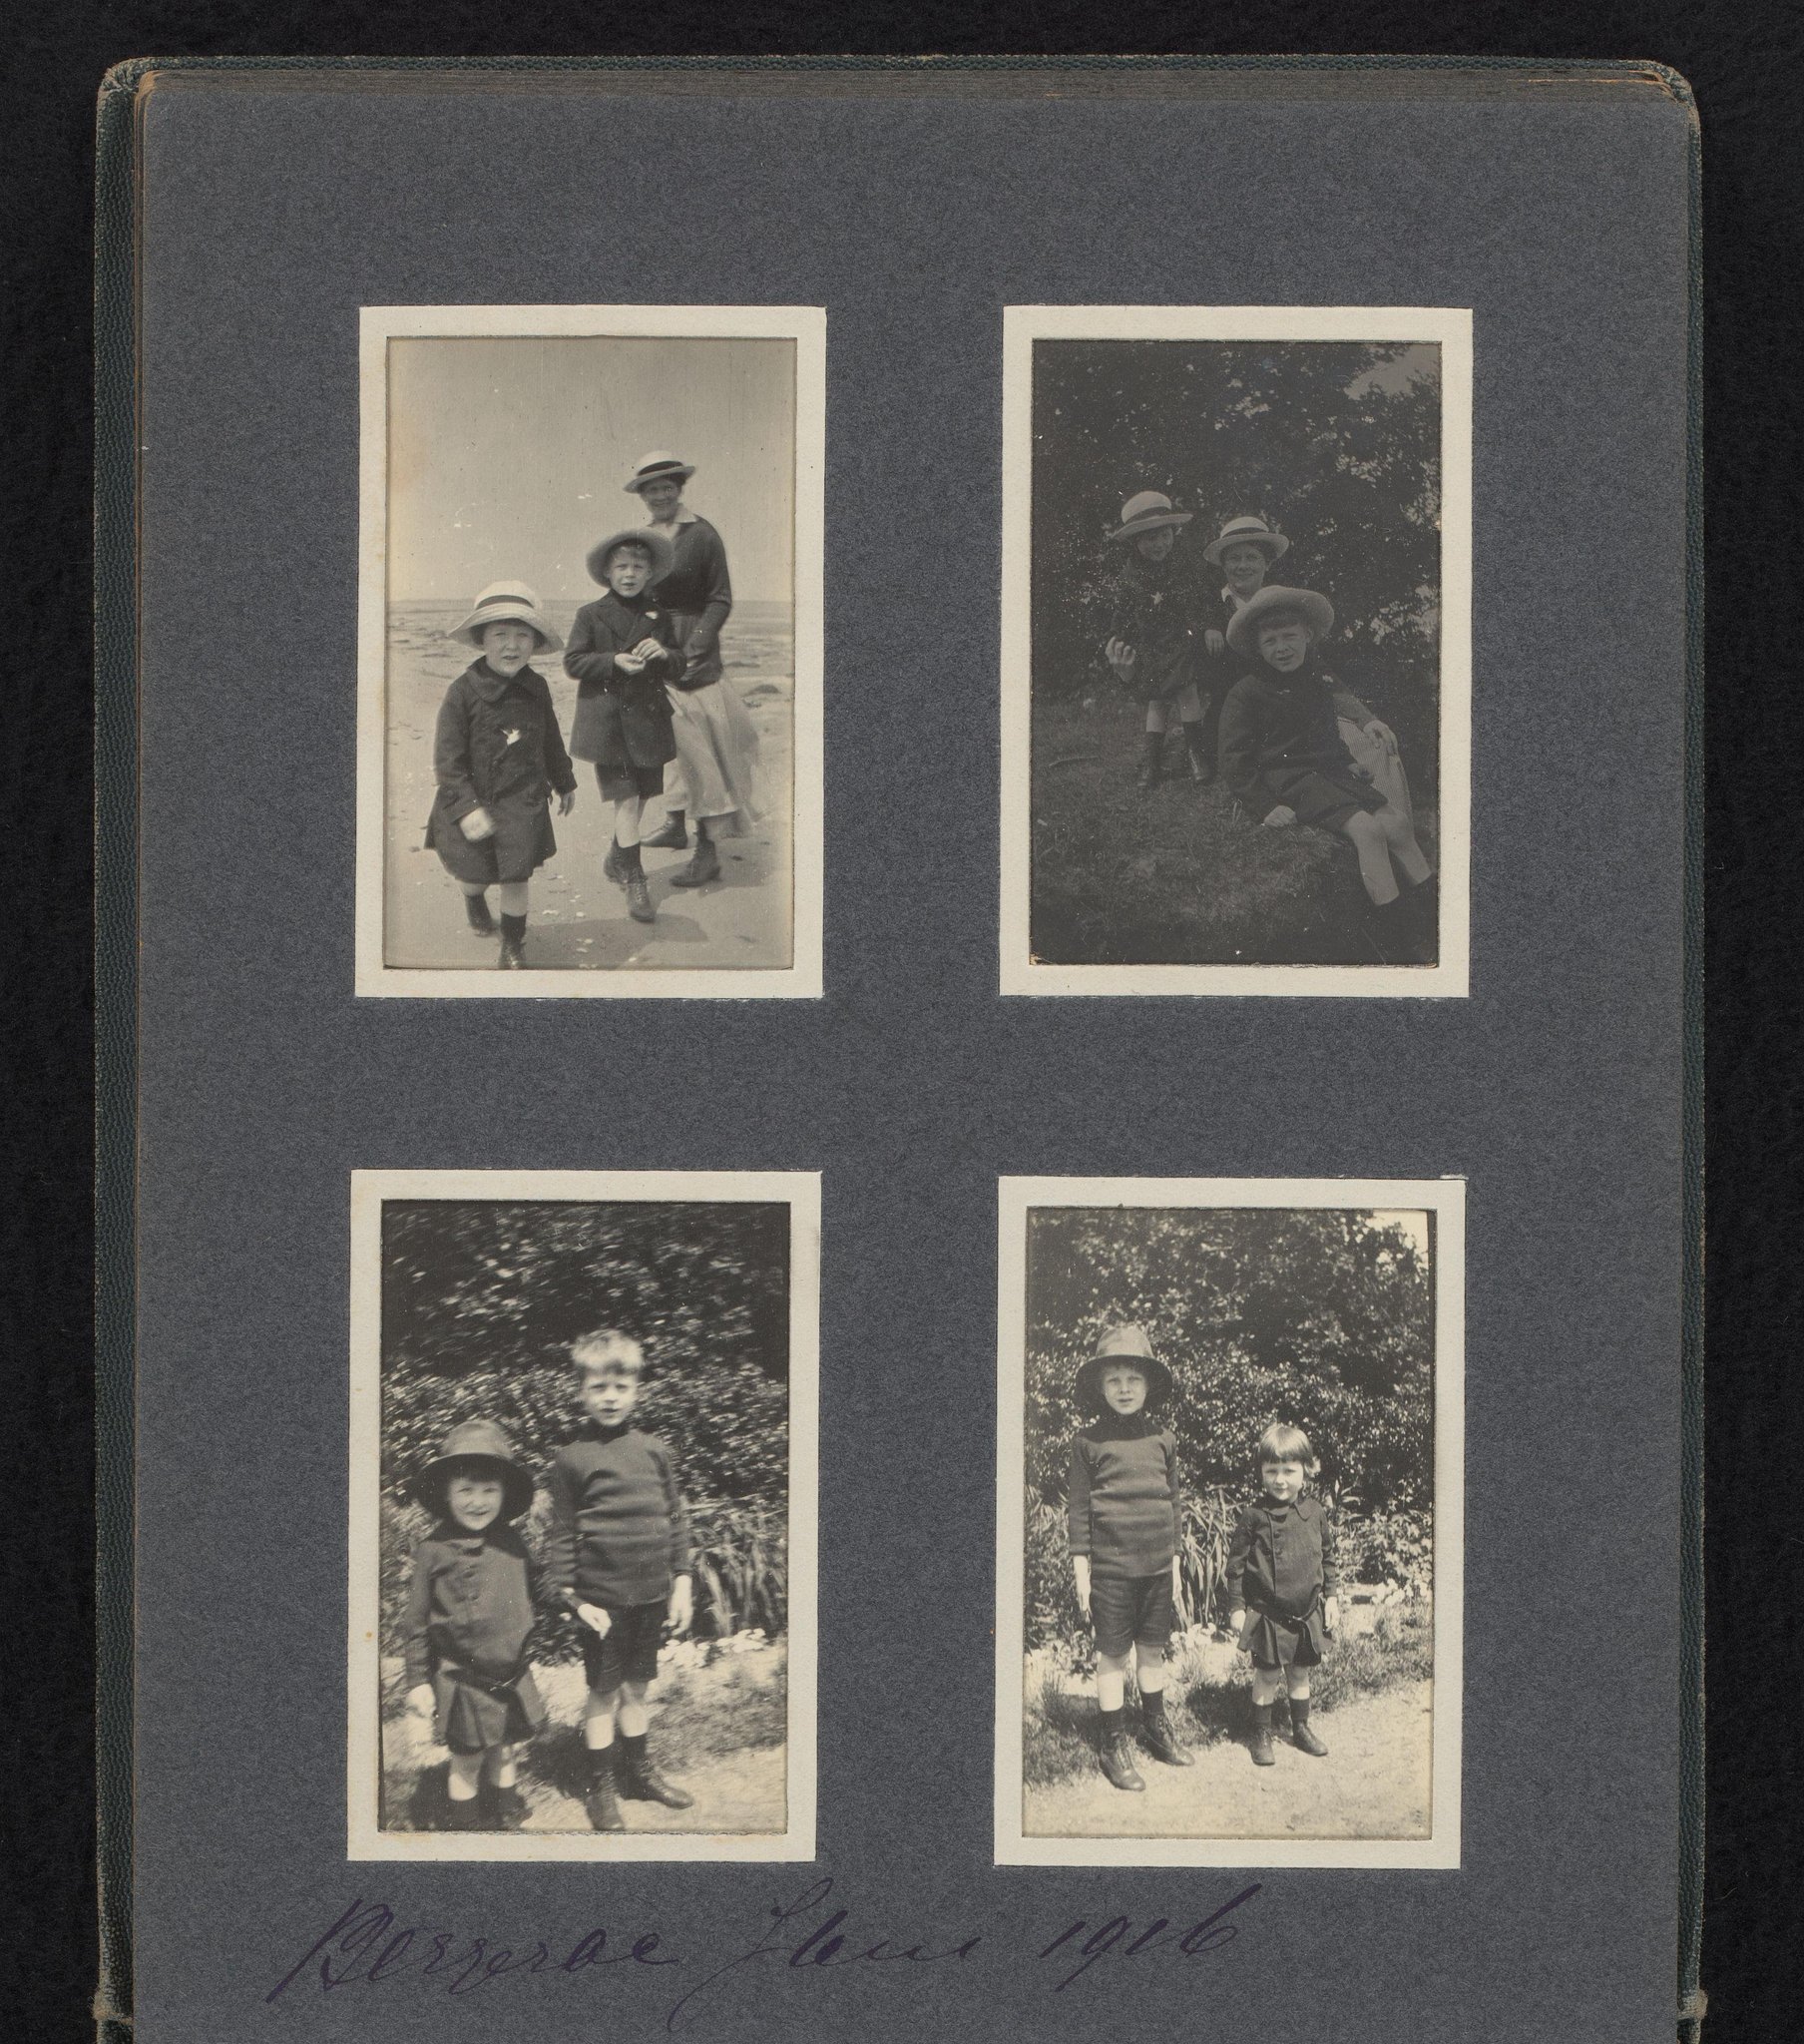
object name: photograph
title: Caroline, Carel en Frank van den Berg in Bergerac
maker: hendrik herman van den berg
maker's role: amateurfotograaf, jurist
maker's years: 1875-1944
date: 1906-1916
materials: paper, cardboard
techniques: gelatin silver print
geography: bergerac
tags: the hague, caroline louise van den berg-van den berg, carel frederik van den berg (cay), frank willem van den berg (1912-1998), mother and son(s) (family group)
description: Deze foto's zijn onderdeel van een album.